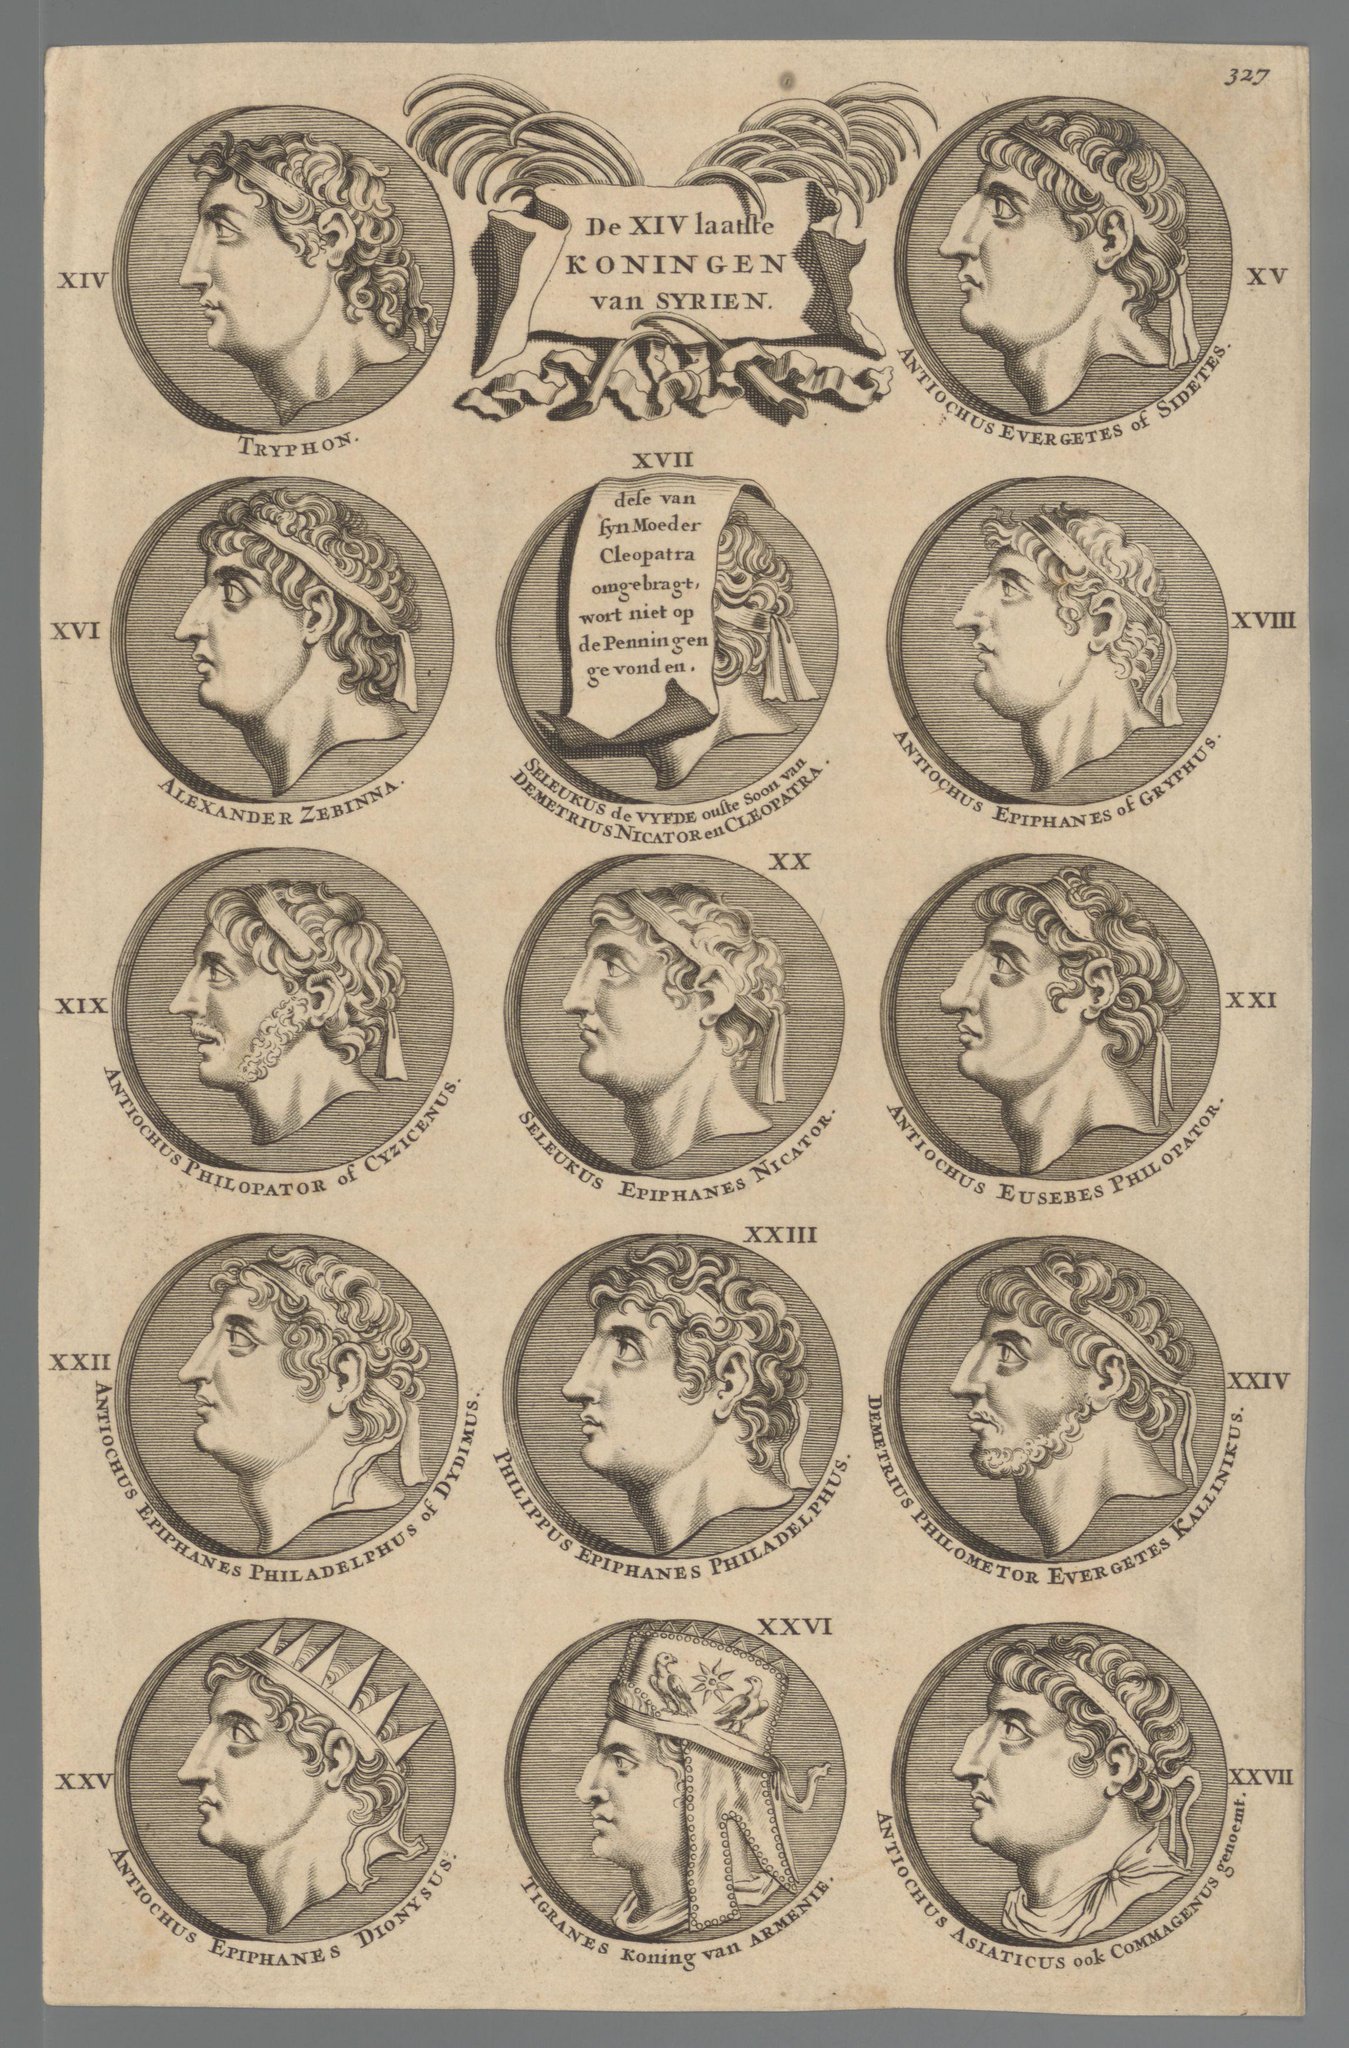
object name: print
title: Medailles met dertien portretten van Syrische koningen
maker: Anonymous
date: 1700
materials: paper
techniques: engraving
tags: historical persons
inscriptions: watermark, collector's mark: Lugt 2228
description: Rechtsboven genummerd met pen: 320. Portretten van Seleucus I Nicator, Antiochus I Soter, Antiochus II Theos, Seleucus II Callinicus, Seleucus III Ceraunus, Antiochus III de Grote, Seleucus IV Philopator, Antiochus V Eupator, Demetrius I Soter, Alexander Balas, Demetrius II Nicator en Sidetes.